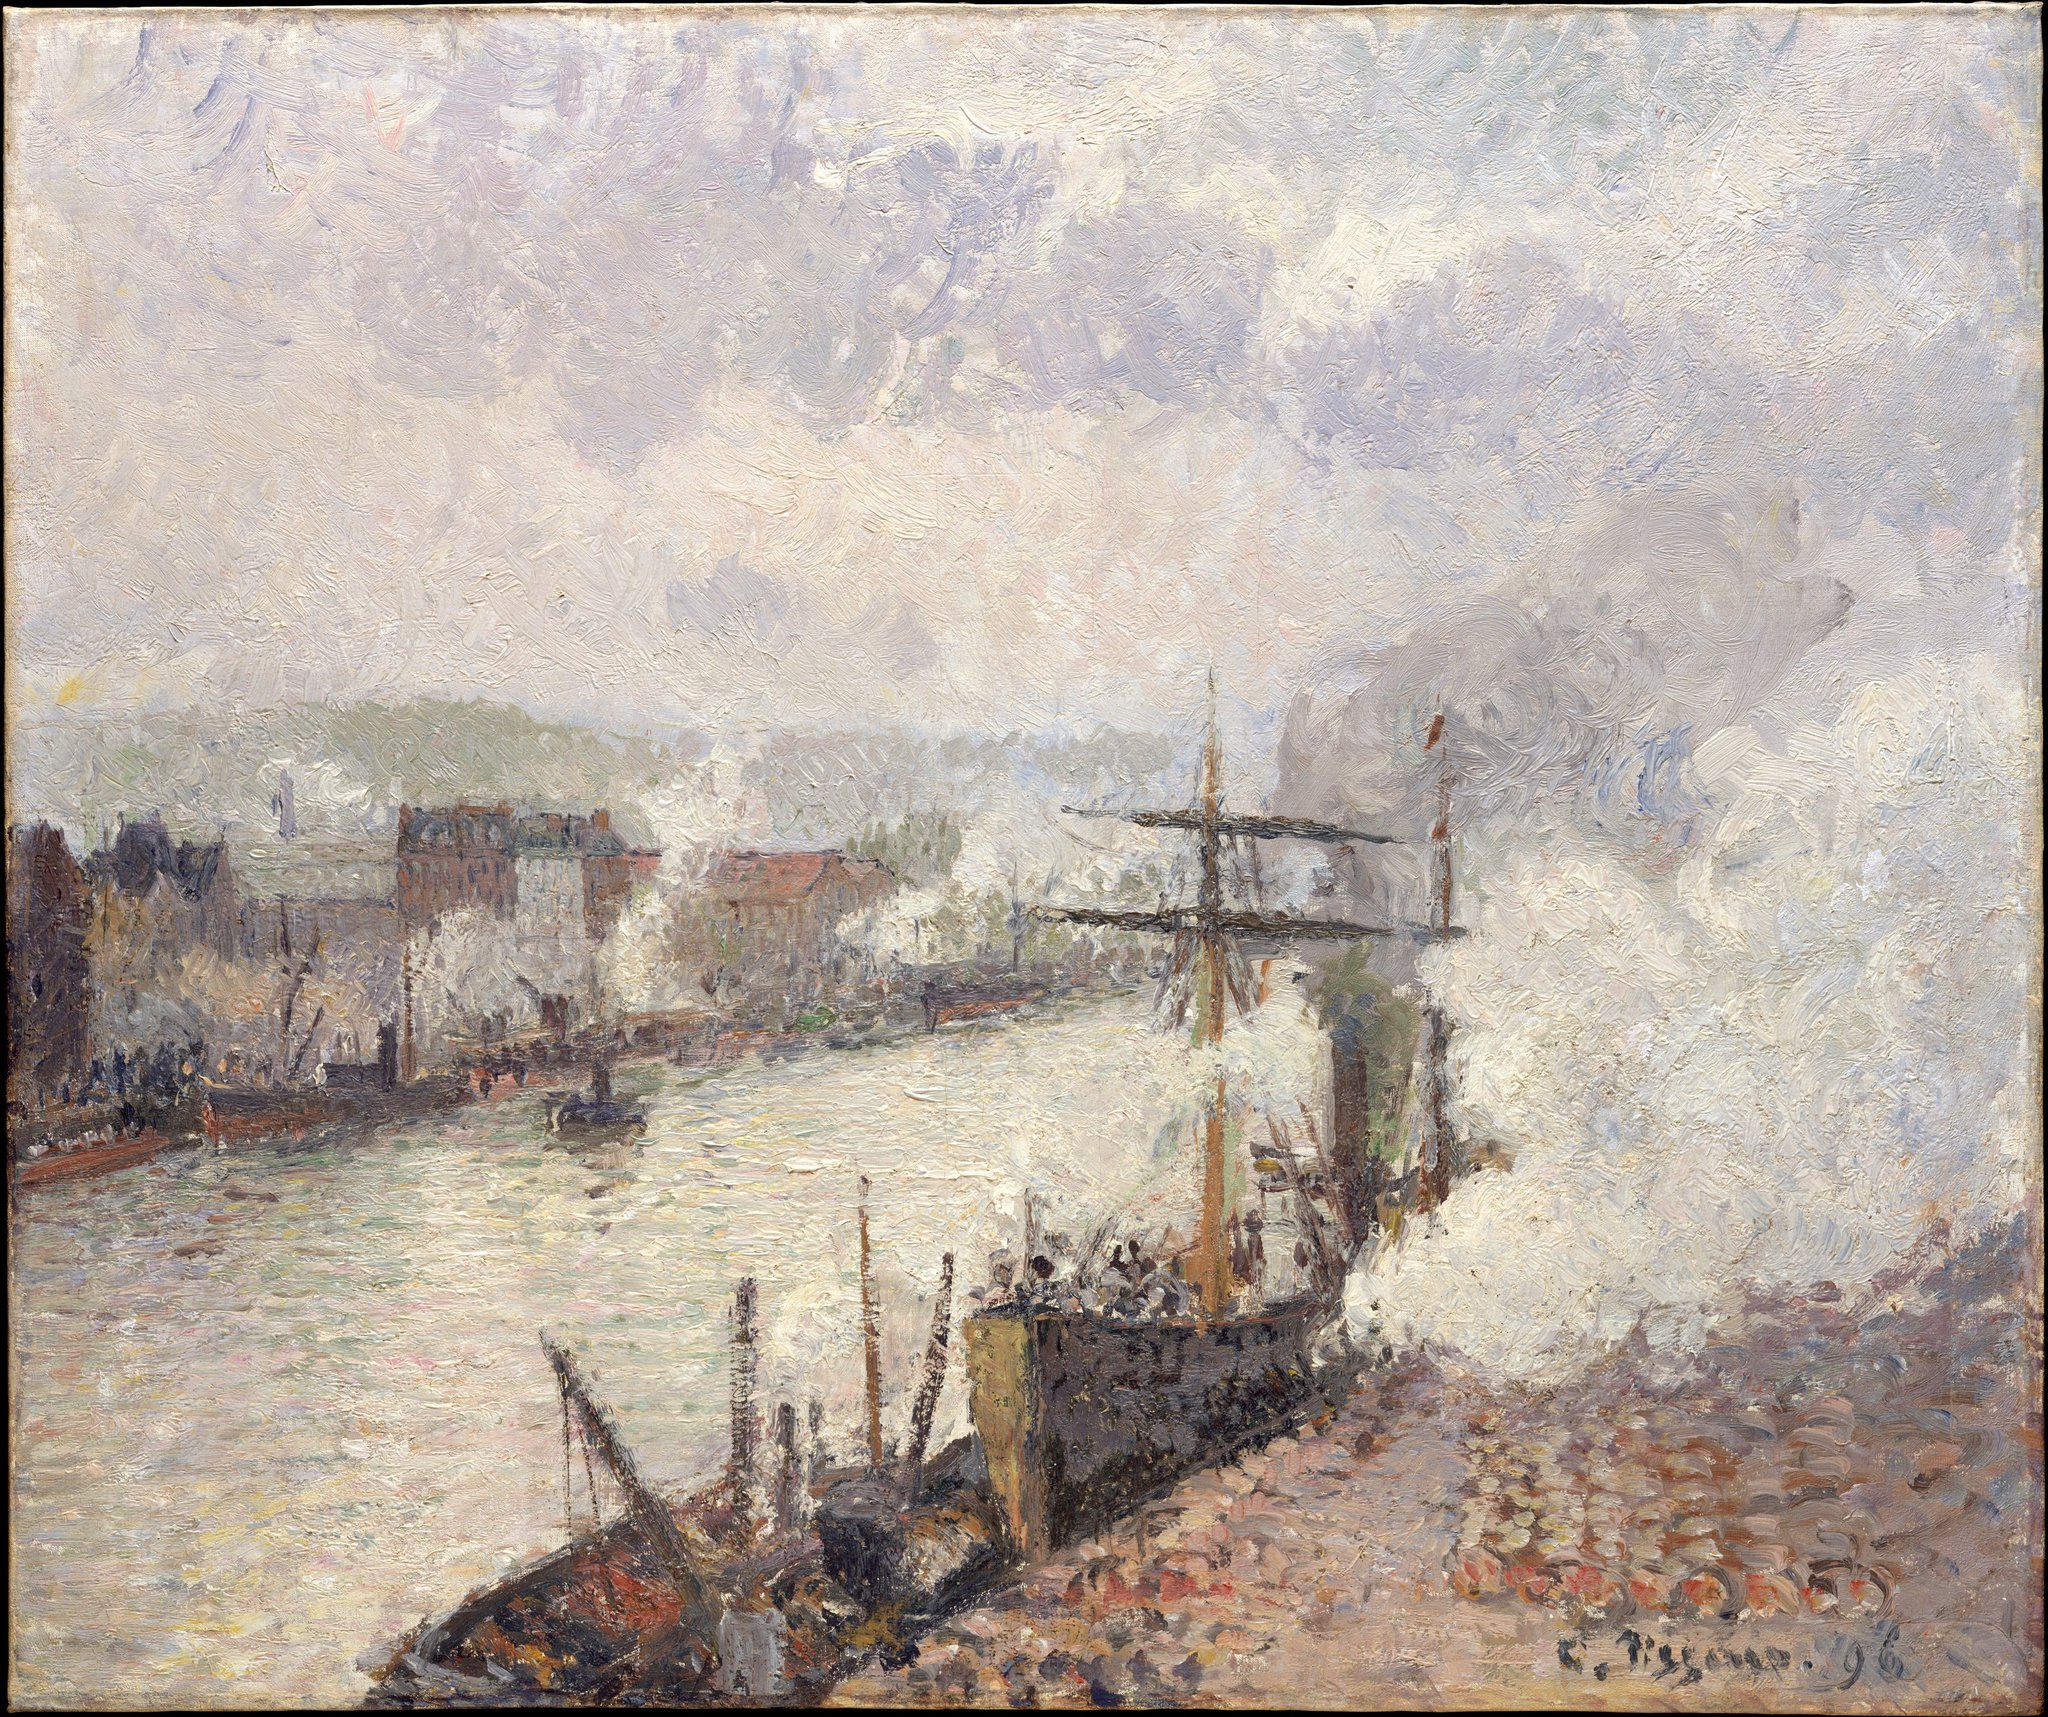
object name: painting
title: Steamboats in the Port of Rouen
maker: camille pissarro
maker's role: artist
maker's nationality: french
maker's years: 1830-1903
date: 1896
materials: canvas, oil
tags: rivers,boats